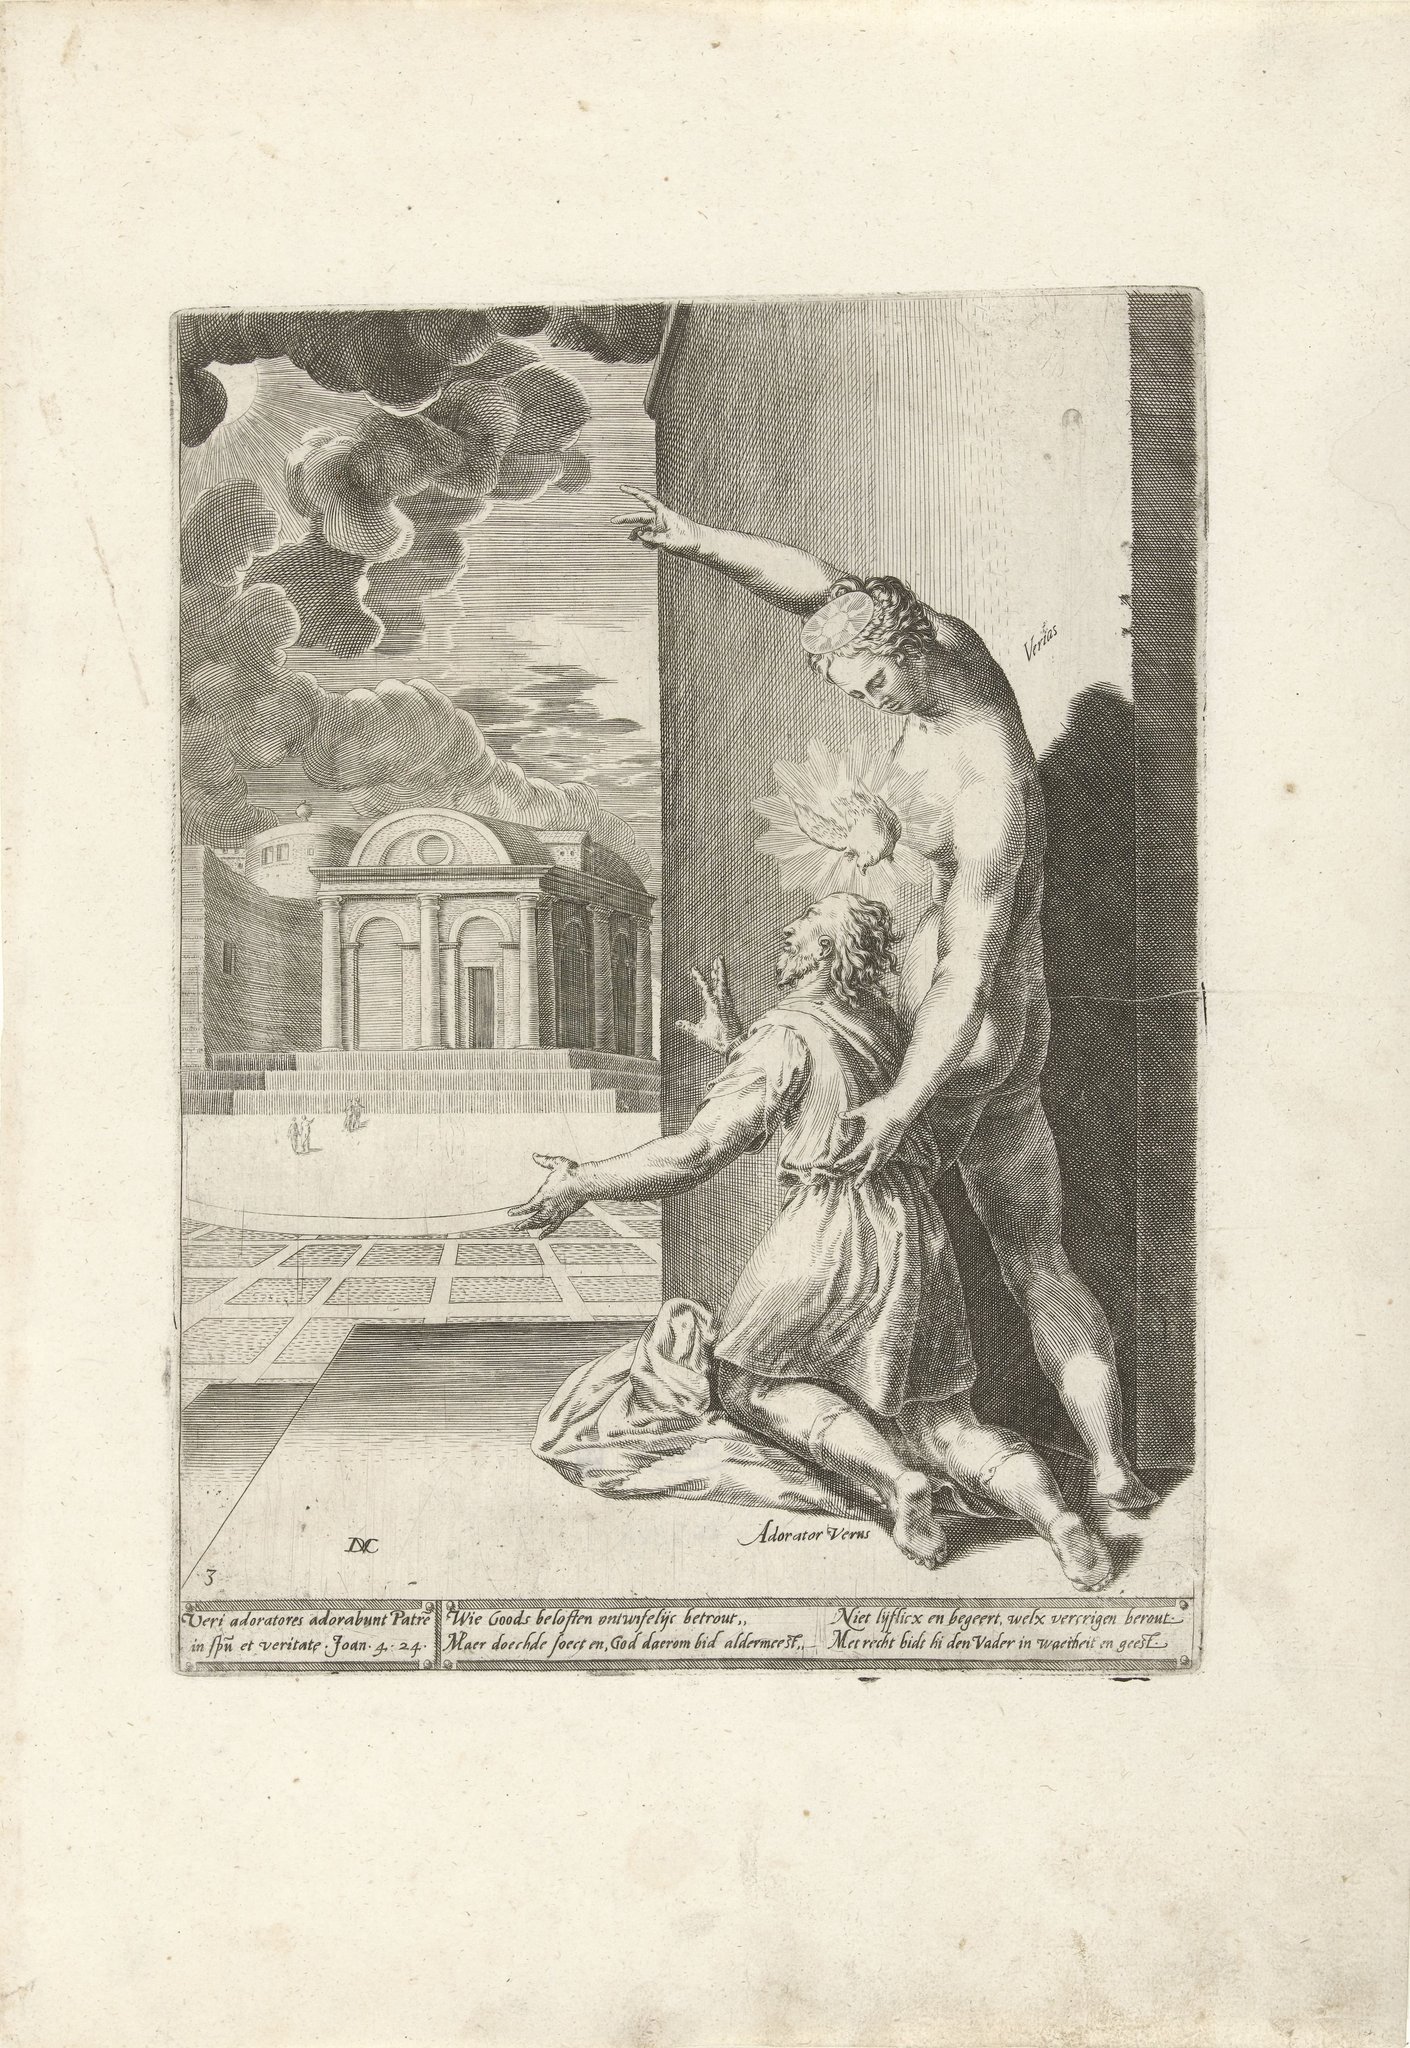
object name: print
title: Waarheid leert de mens God aanbidden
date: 1566-1578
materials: paper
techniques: engraving, etching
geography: germany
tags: true religion vs. false religion, truth; 'verità' (ripa), (rays of) light ~ symbol of god the father, devotion, piety; 'divotione' (ripa) (+ holy ghost (as a dove))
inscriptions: collector's mark: Lugt 2228, collector's mark: Lugt 2760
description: De Ware Gelovige (Adorator Verus) wordt door Waarheid begeleid. Zij wijst hem het stralende licht van God dat vanachter duistere wolken tevoorschijn komt. Door zich te laten leiden door Waarheid, wordt de Ware Gelovige bezocht door de Heilige Geest (een duif). De prent heeft een Latijns en een Nederlands onderschrift en maakt deel uit van een serie over de triomf van de waarheid.